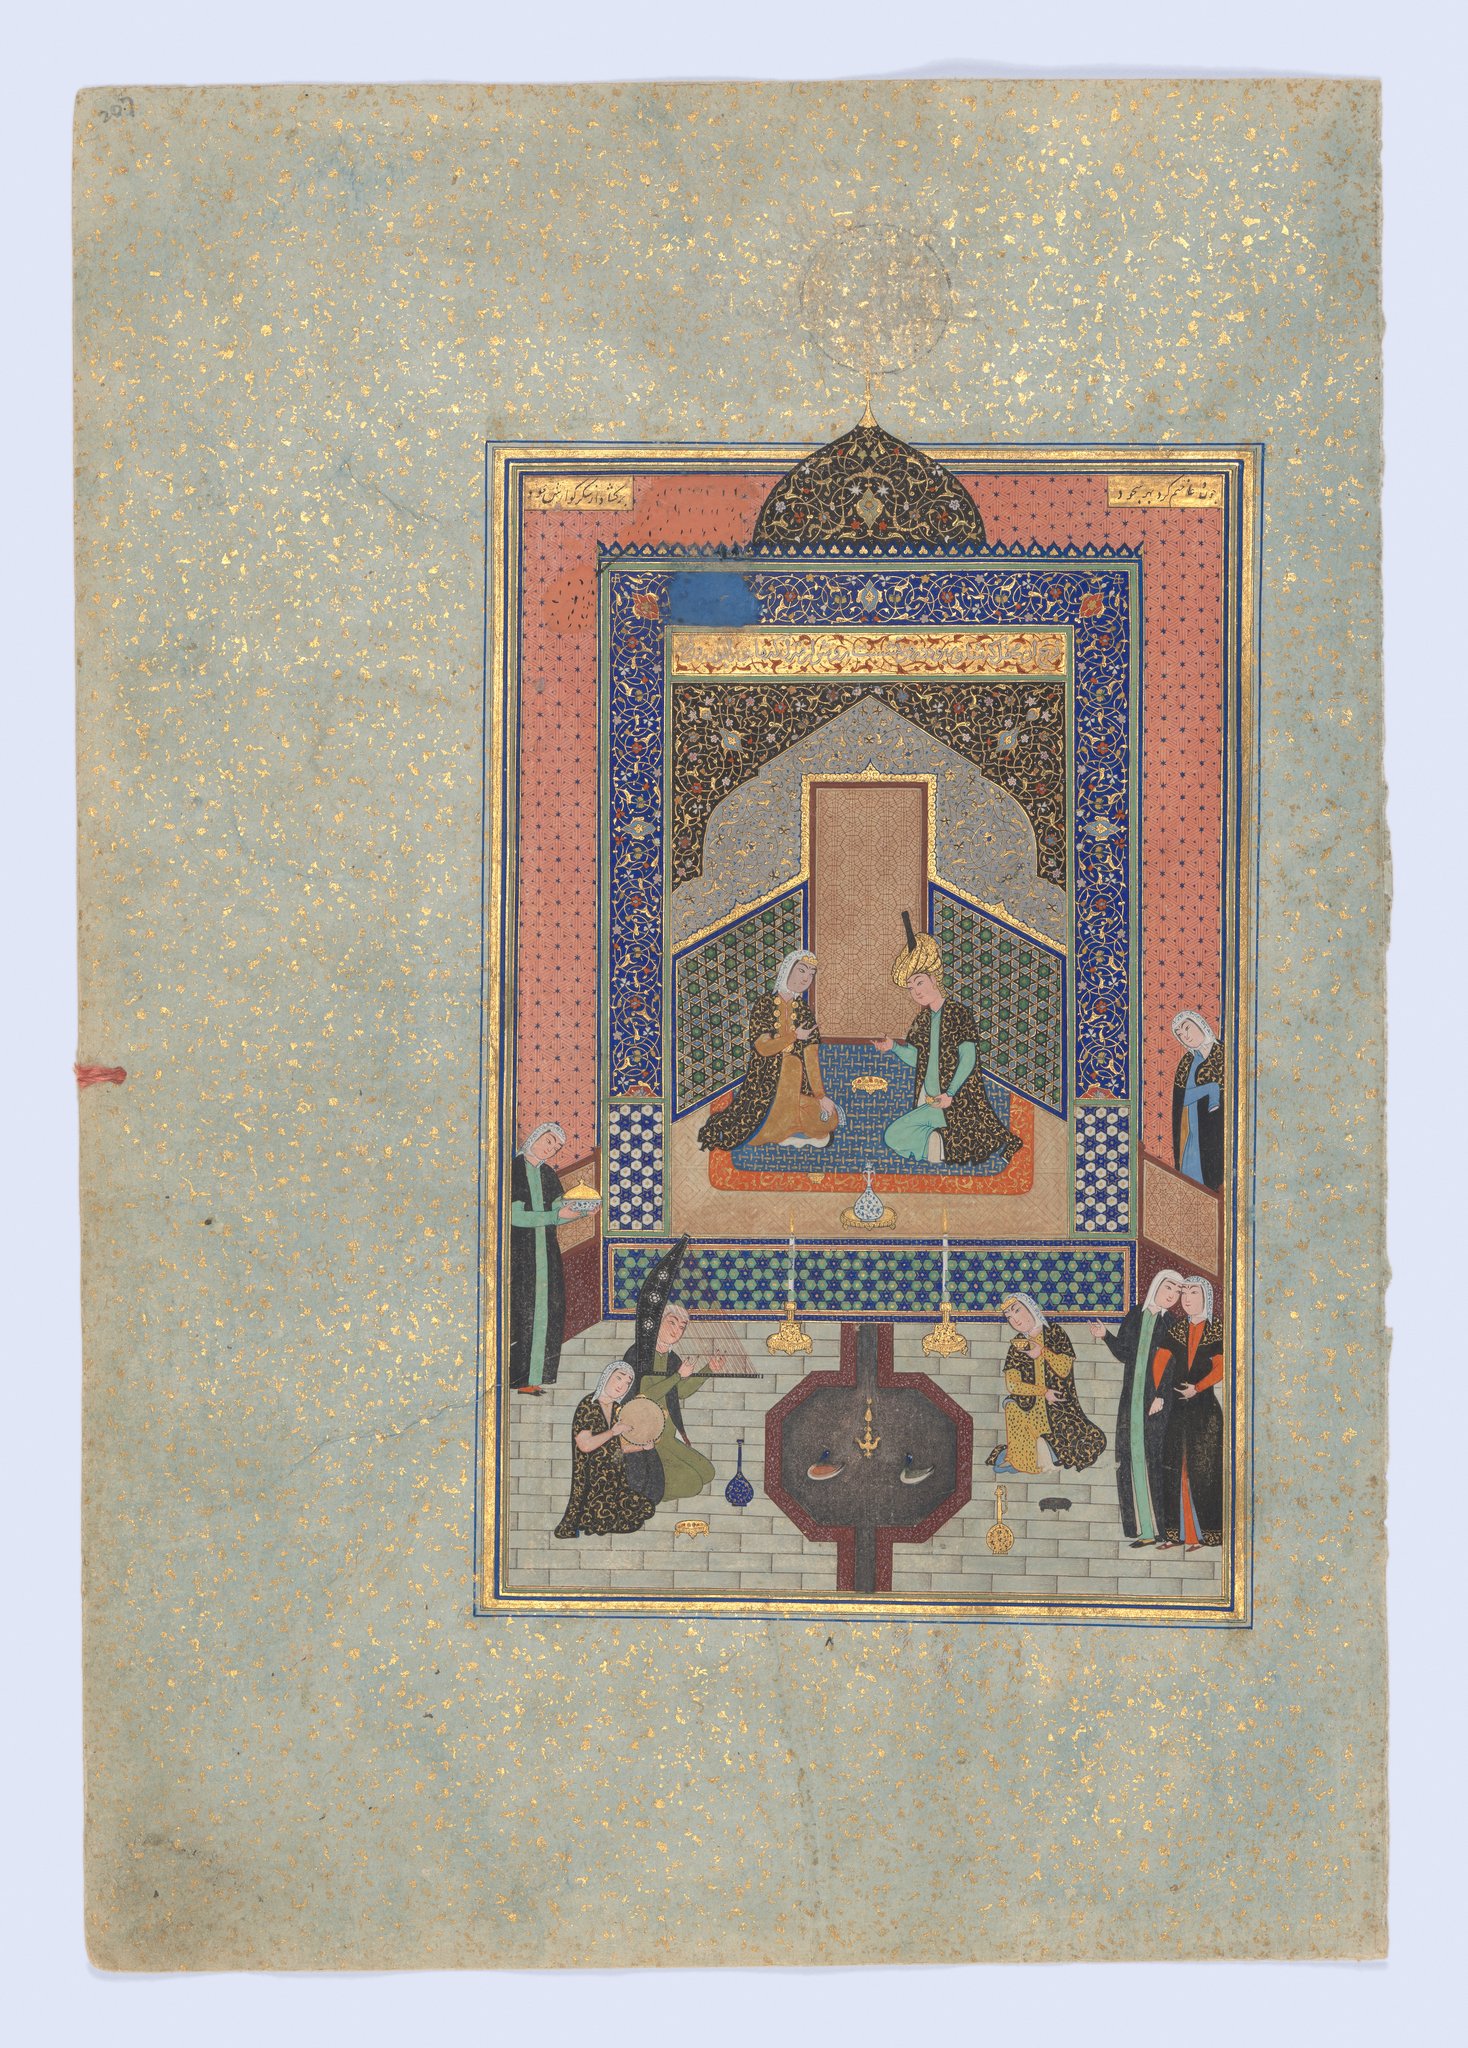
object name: folio from an illustrated manuscript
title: "Bahram Gur in the Dark Palace on Saturday", Folio 207 from a Khamsa (Quintet) of Nizami of Ganja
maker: nizami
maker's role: author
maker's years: 1141-1209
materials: gold, ink, paper, silver, watercolor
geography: afghanistan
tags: musical instruments,kings,women,music